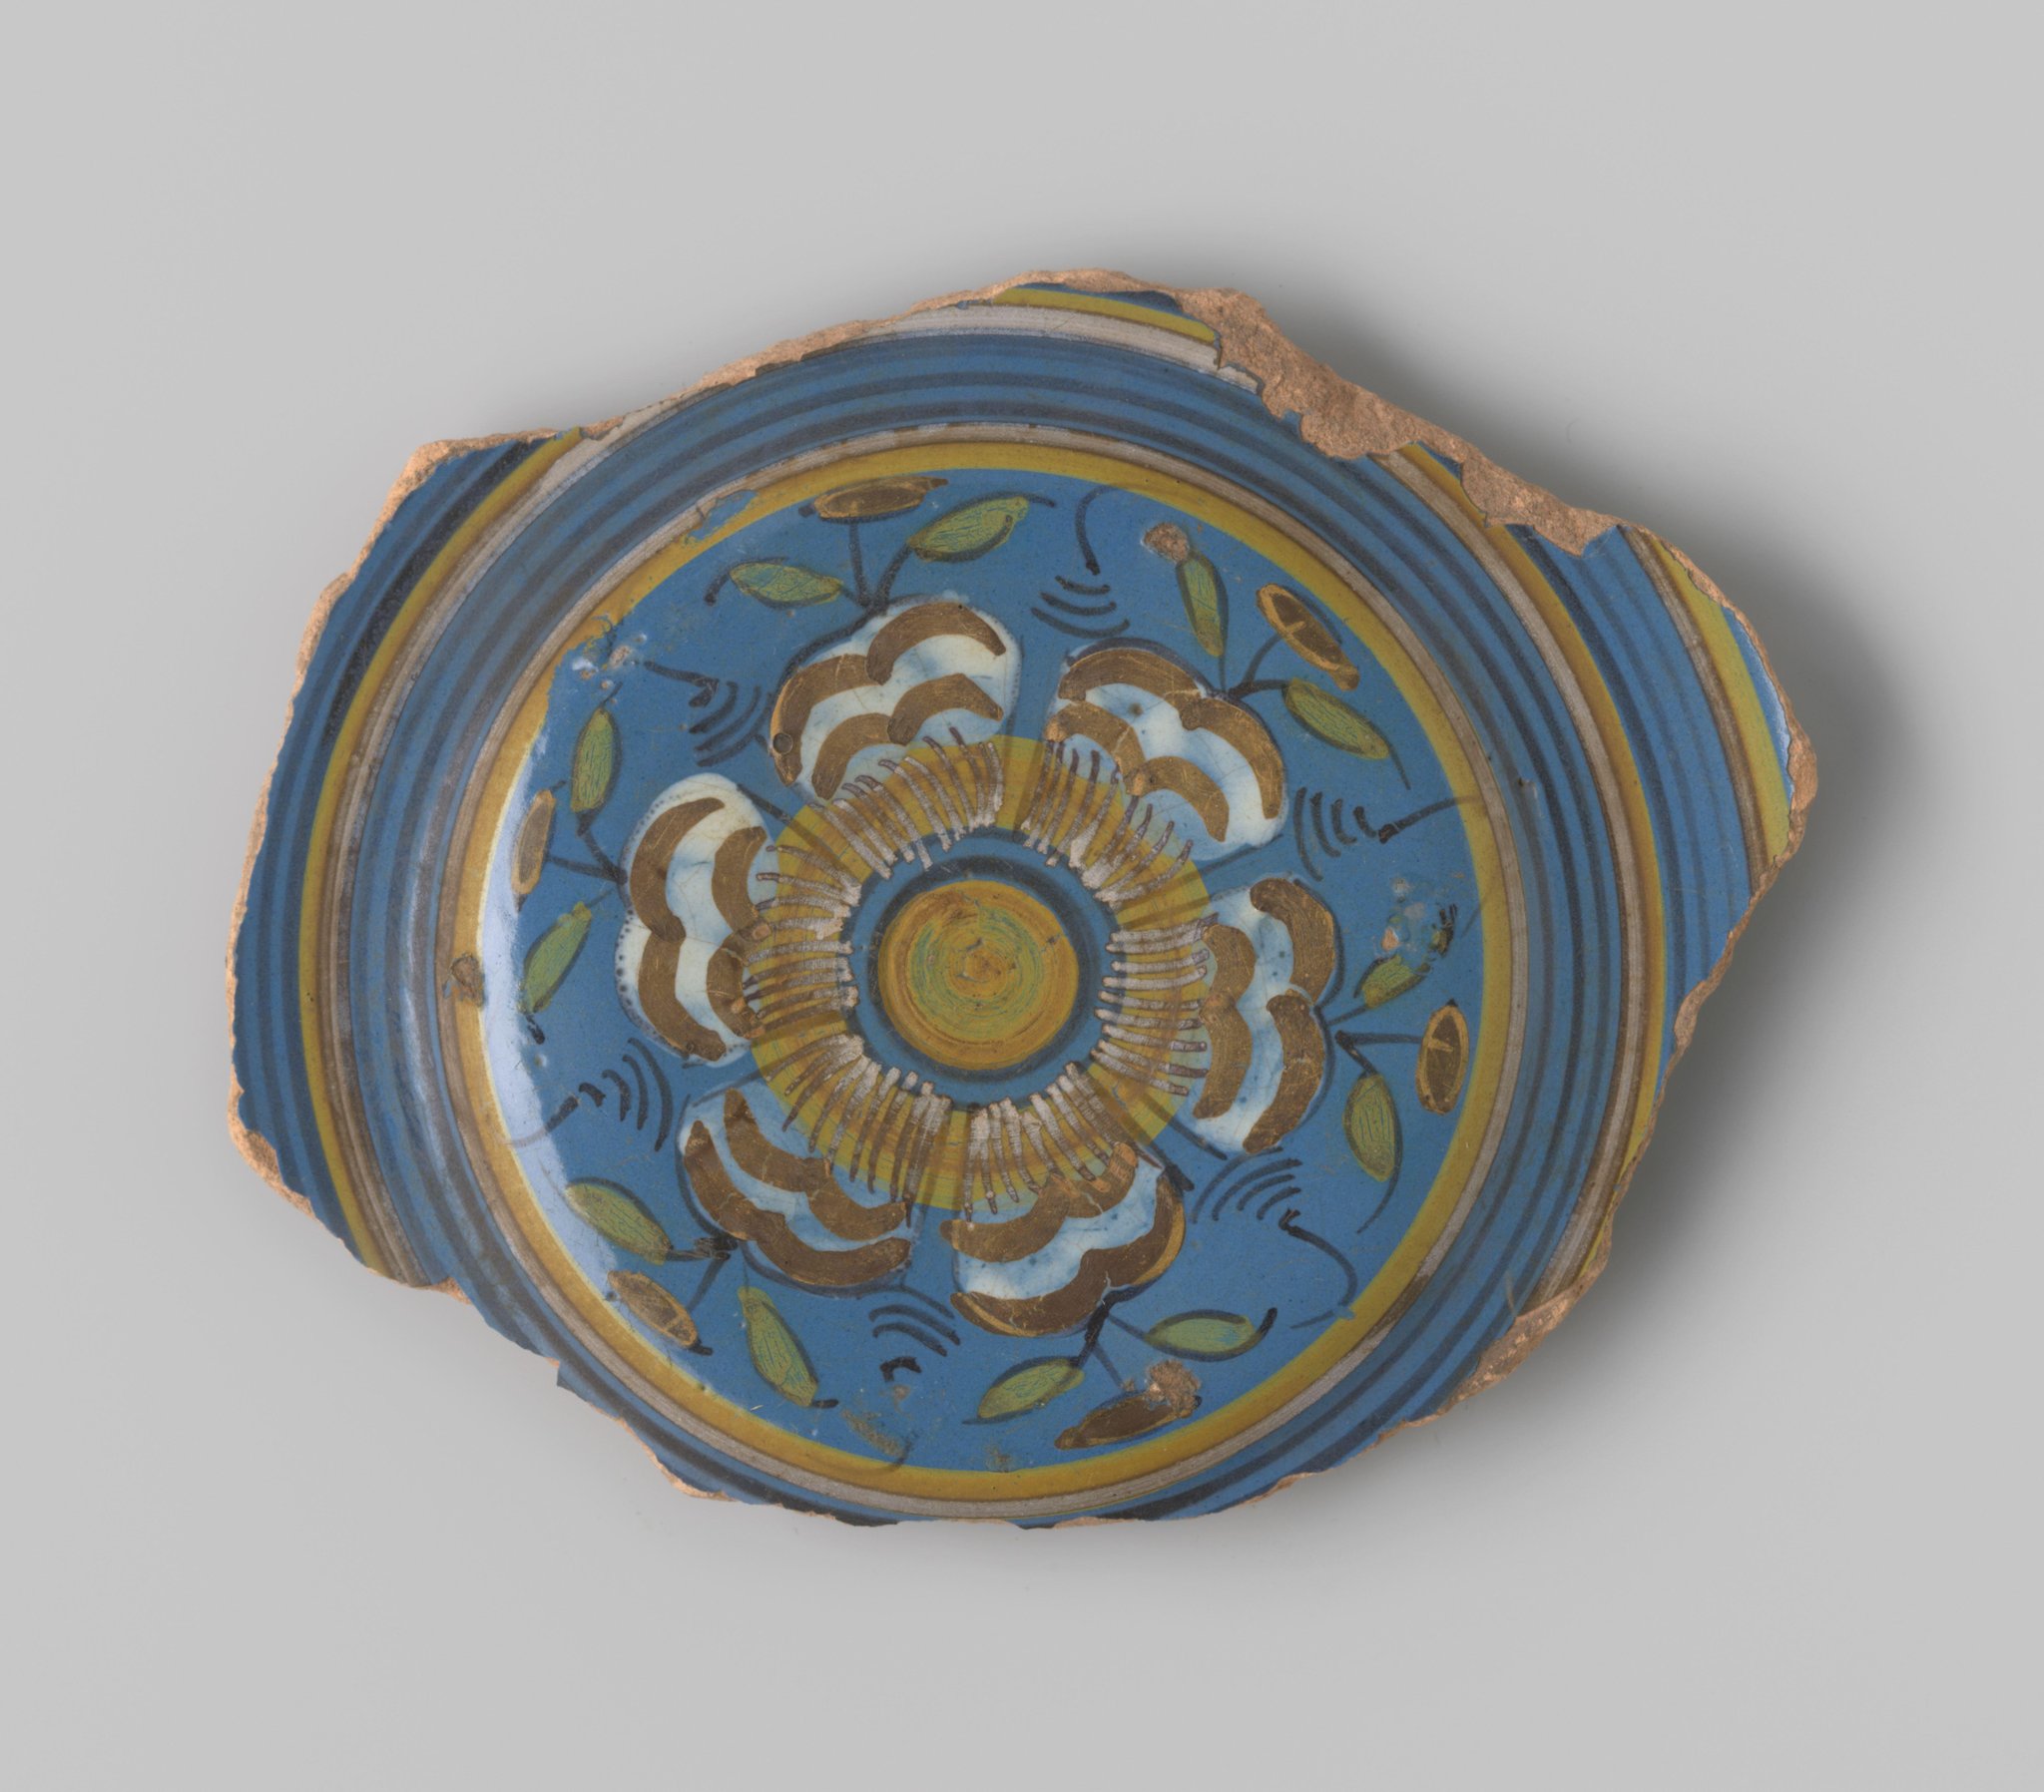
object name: fragment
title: Schotelscherf van rossigbakkend aardewerk, voorzien van blauw glazuur aan de bovenzijde, waarop op het plat een schildering van een omcirkelde bloem in de kleuren wit, bruin, geel, groen en zwart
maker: Anonymous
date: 1500-1699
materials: earthenware, glaze